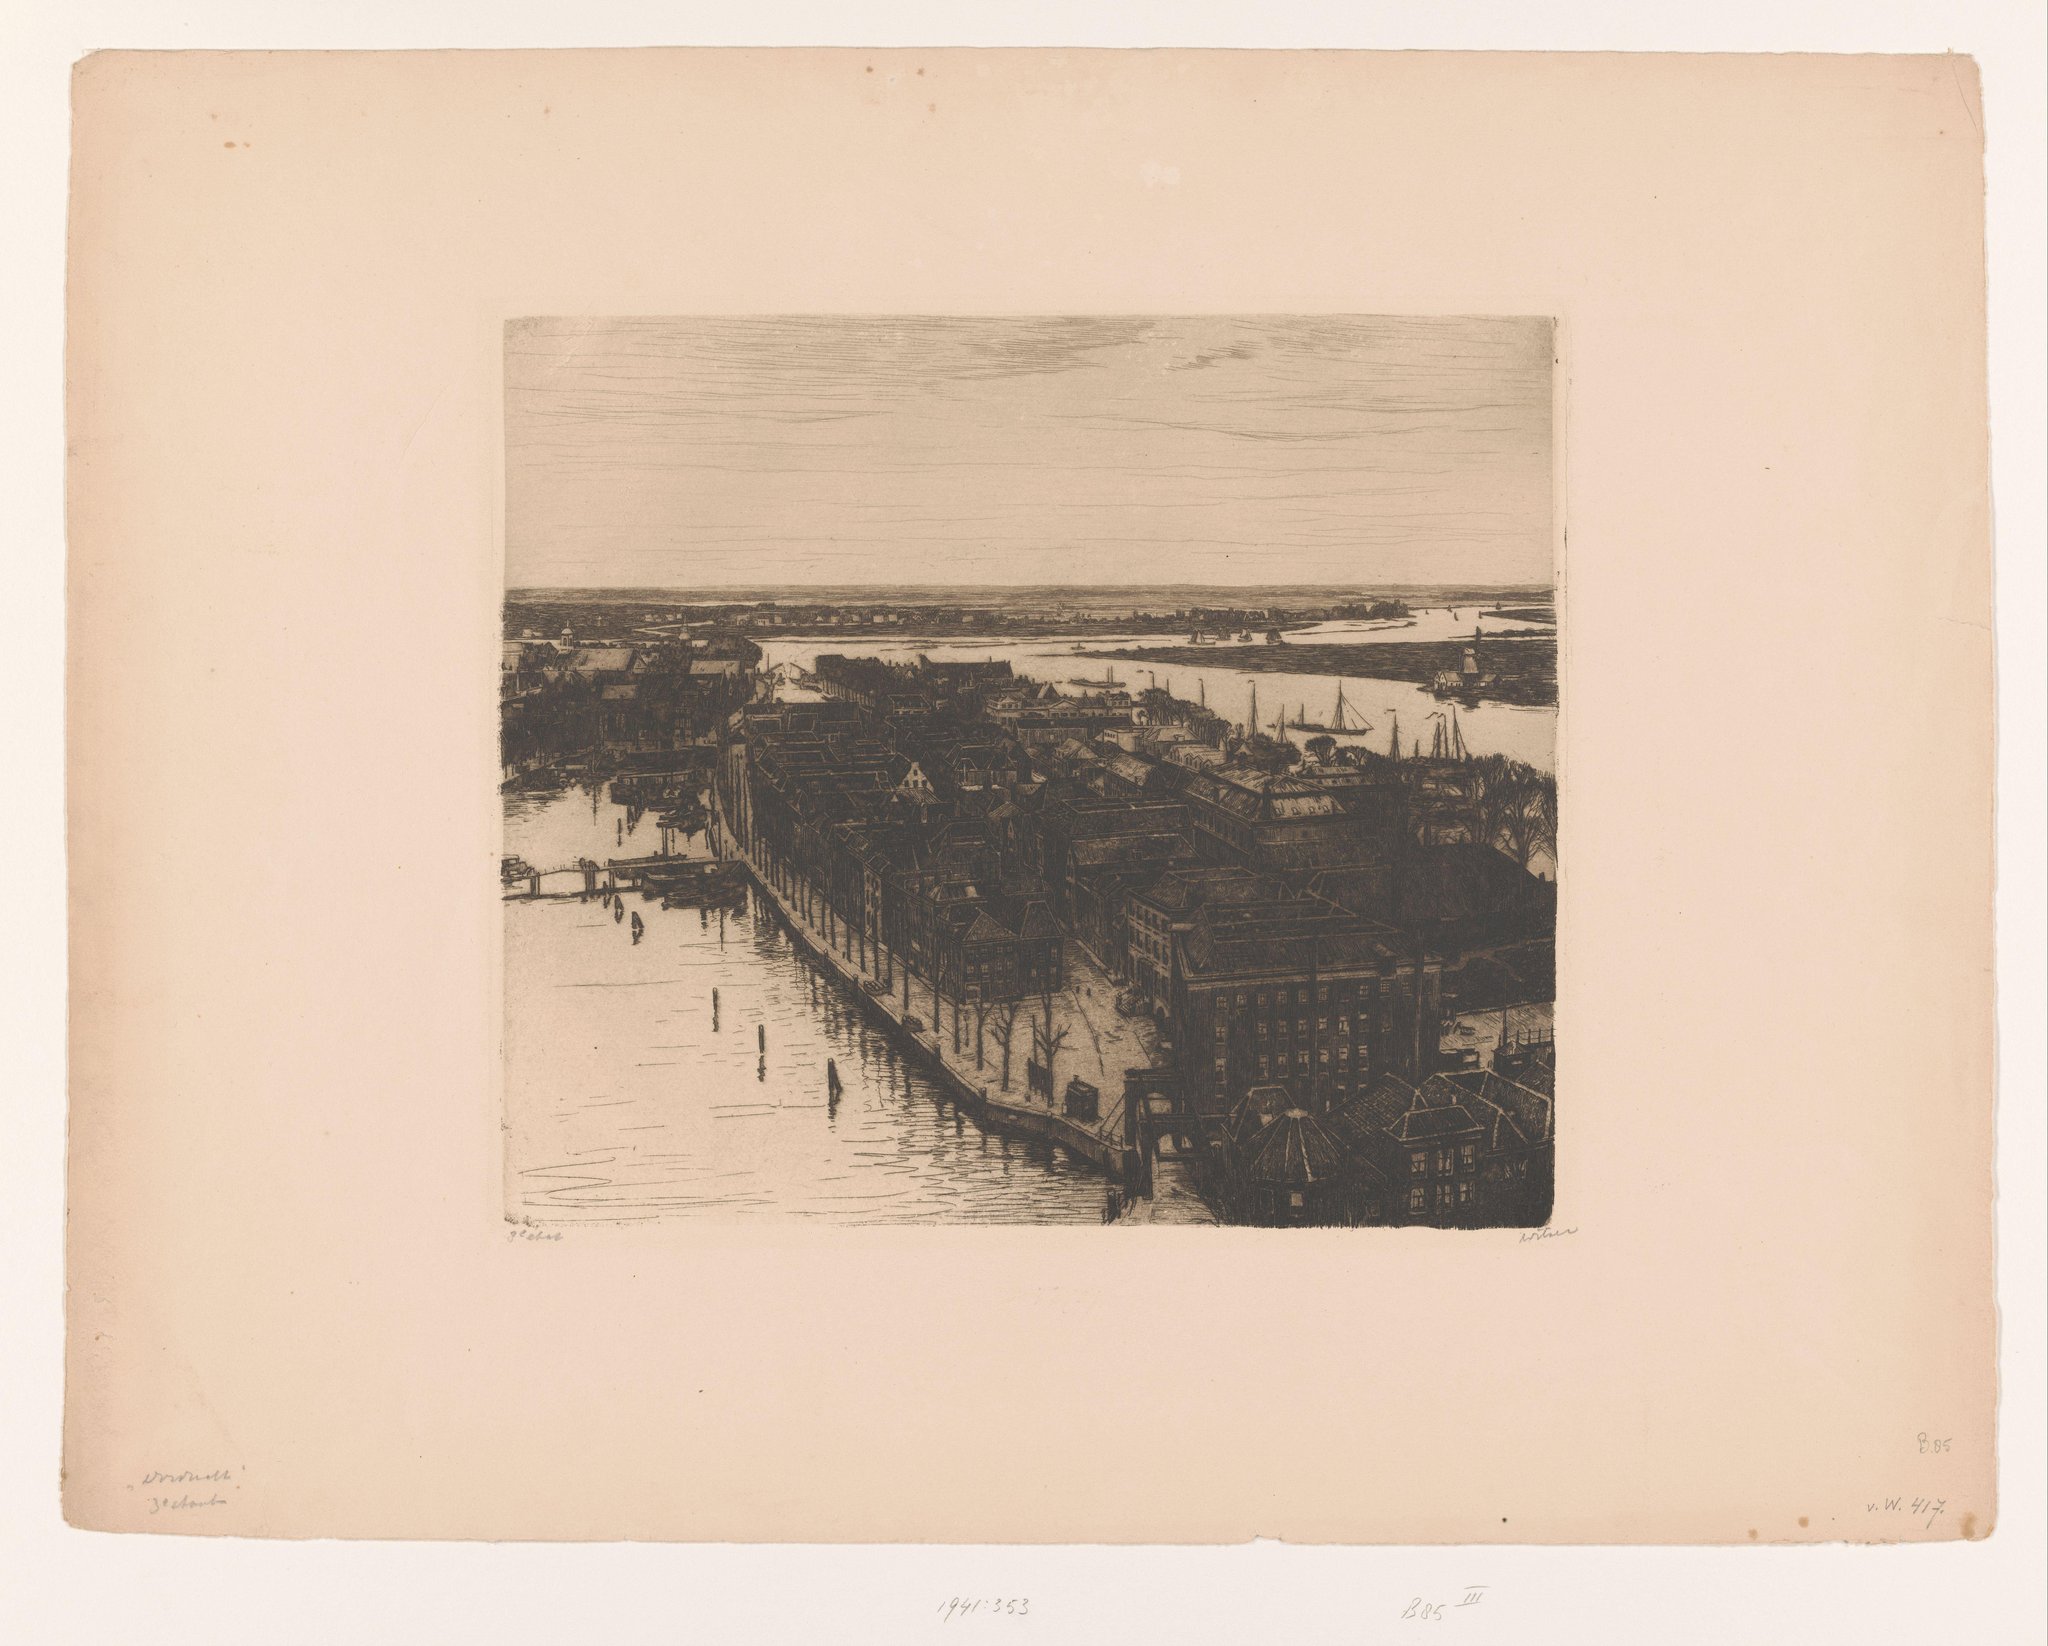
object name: print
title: Haven, Dordrecht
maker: willem witsen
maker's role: draughtsman, painter, print maker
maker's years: 1860-1923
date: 1900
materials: paper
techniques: etching, intaglio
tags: harbour, city-view in general; 'veduta', river, dordrecht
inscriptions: collector's mark: Lugt 2228, collector's mark: Lugt 2760, annotation: ‘3e état’